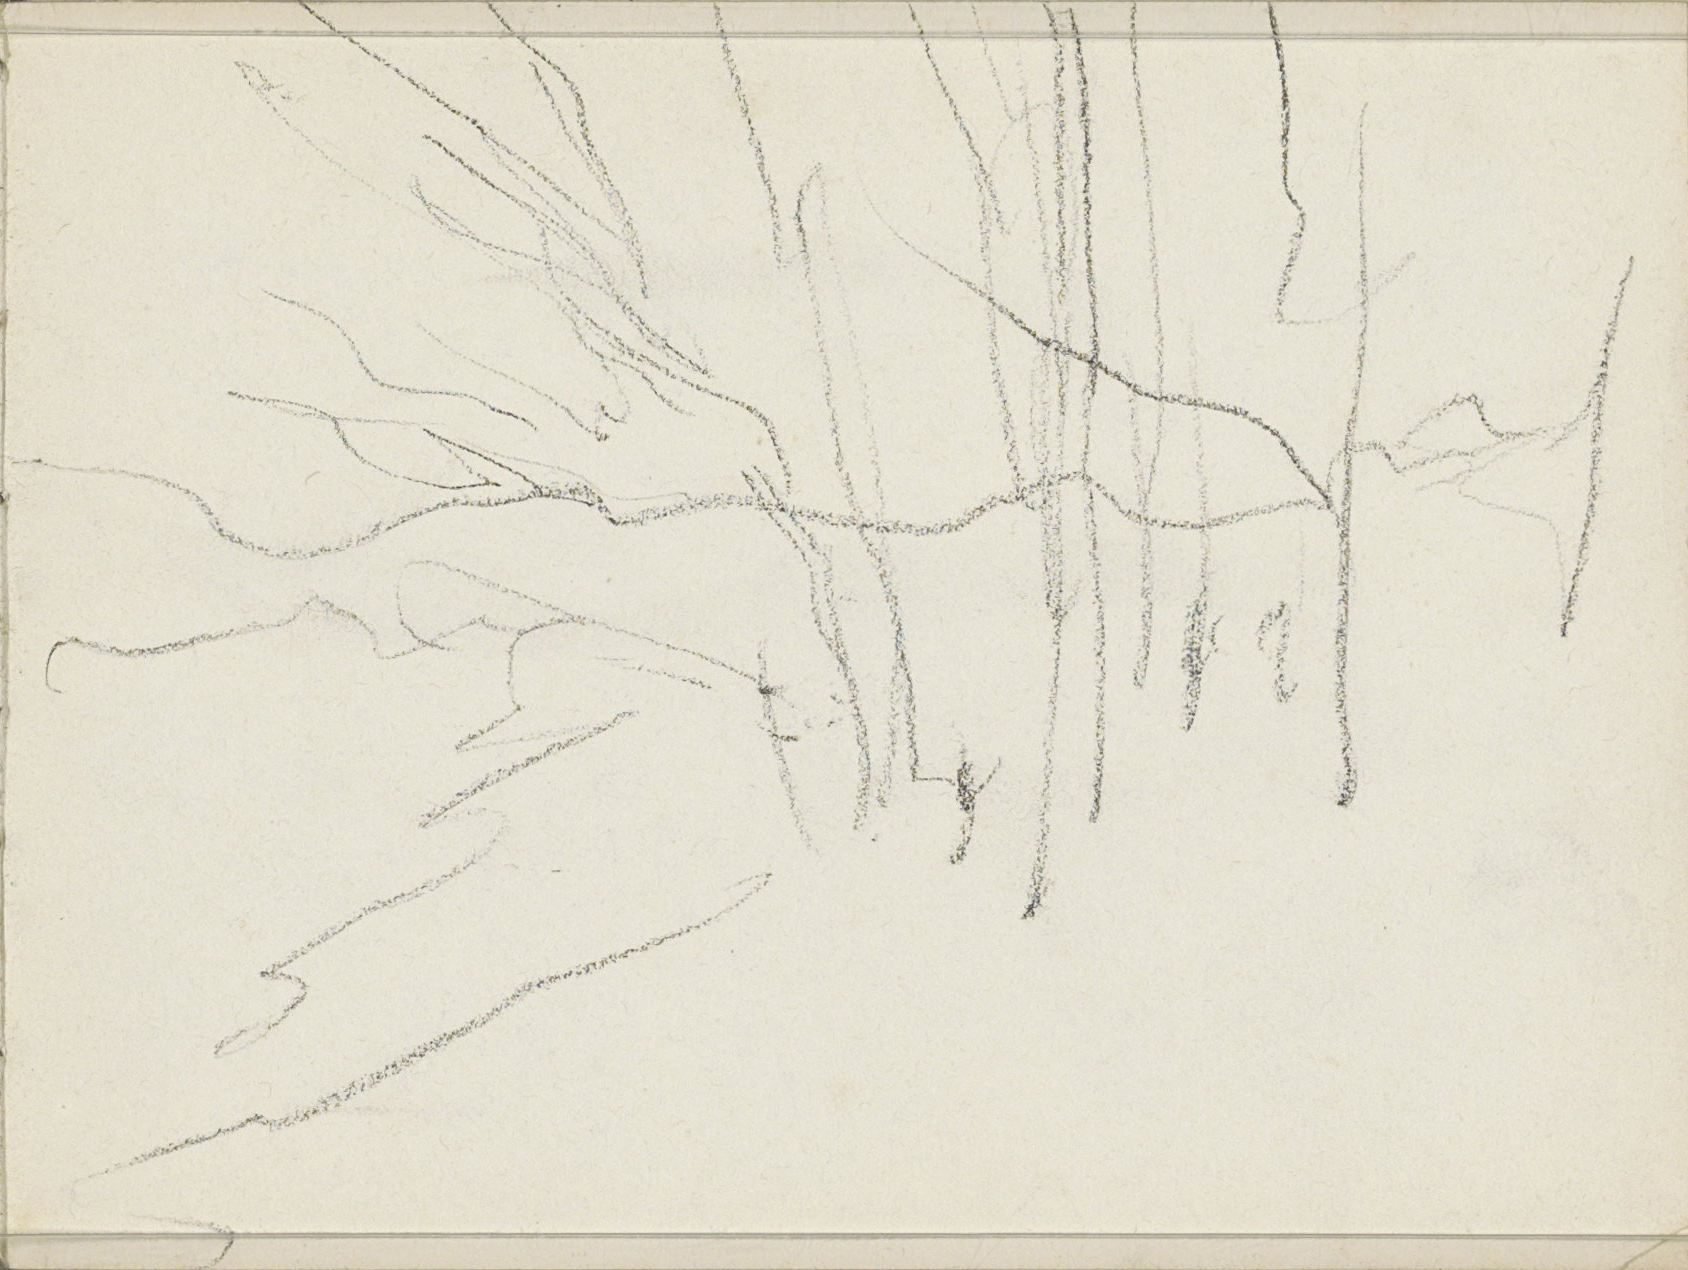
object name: sketchbook leaf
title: Bomen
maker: anton mauve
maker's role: draughtsman, painter, print maker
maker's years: 1838-1888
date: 1881-1888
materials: chalk, paper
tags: trees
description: Blad 16 recto uit een schetsboek met 29 bladen.